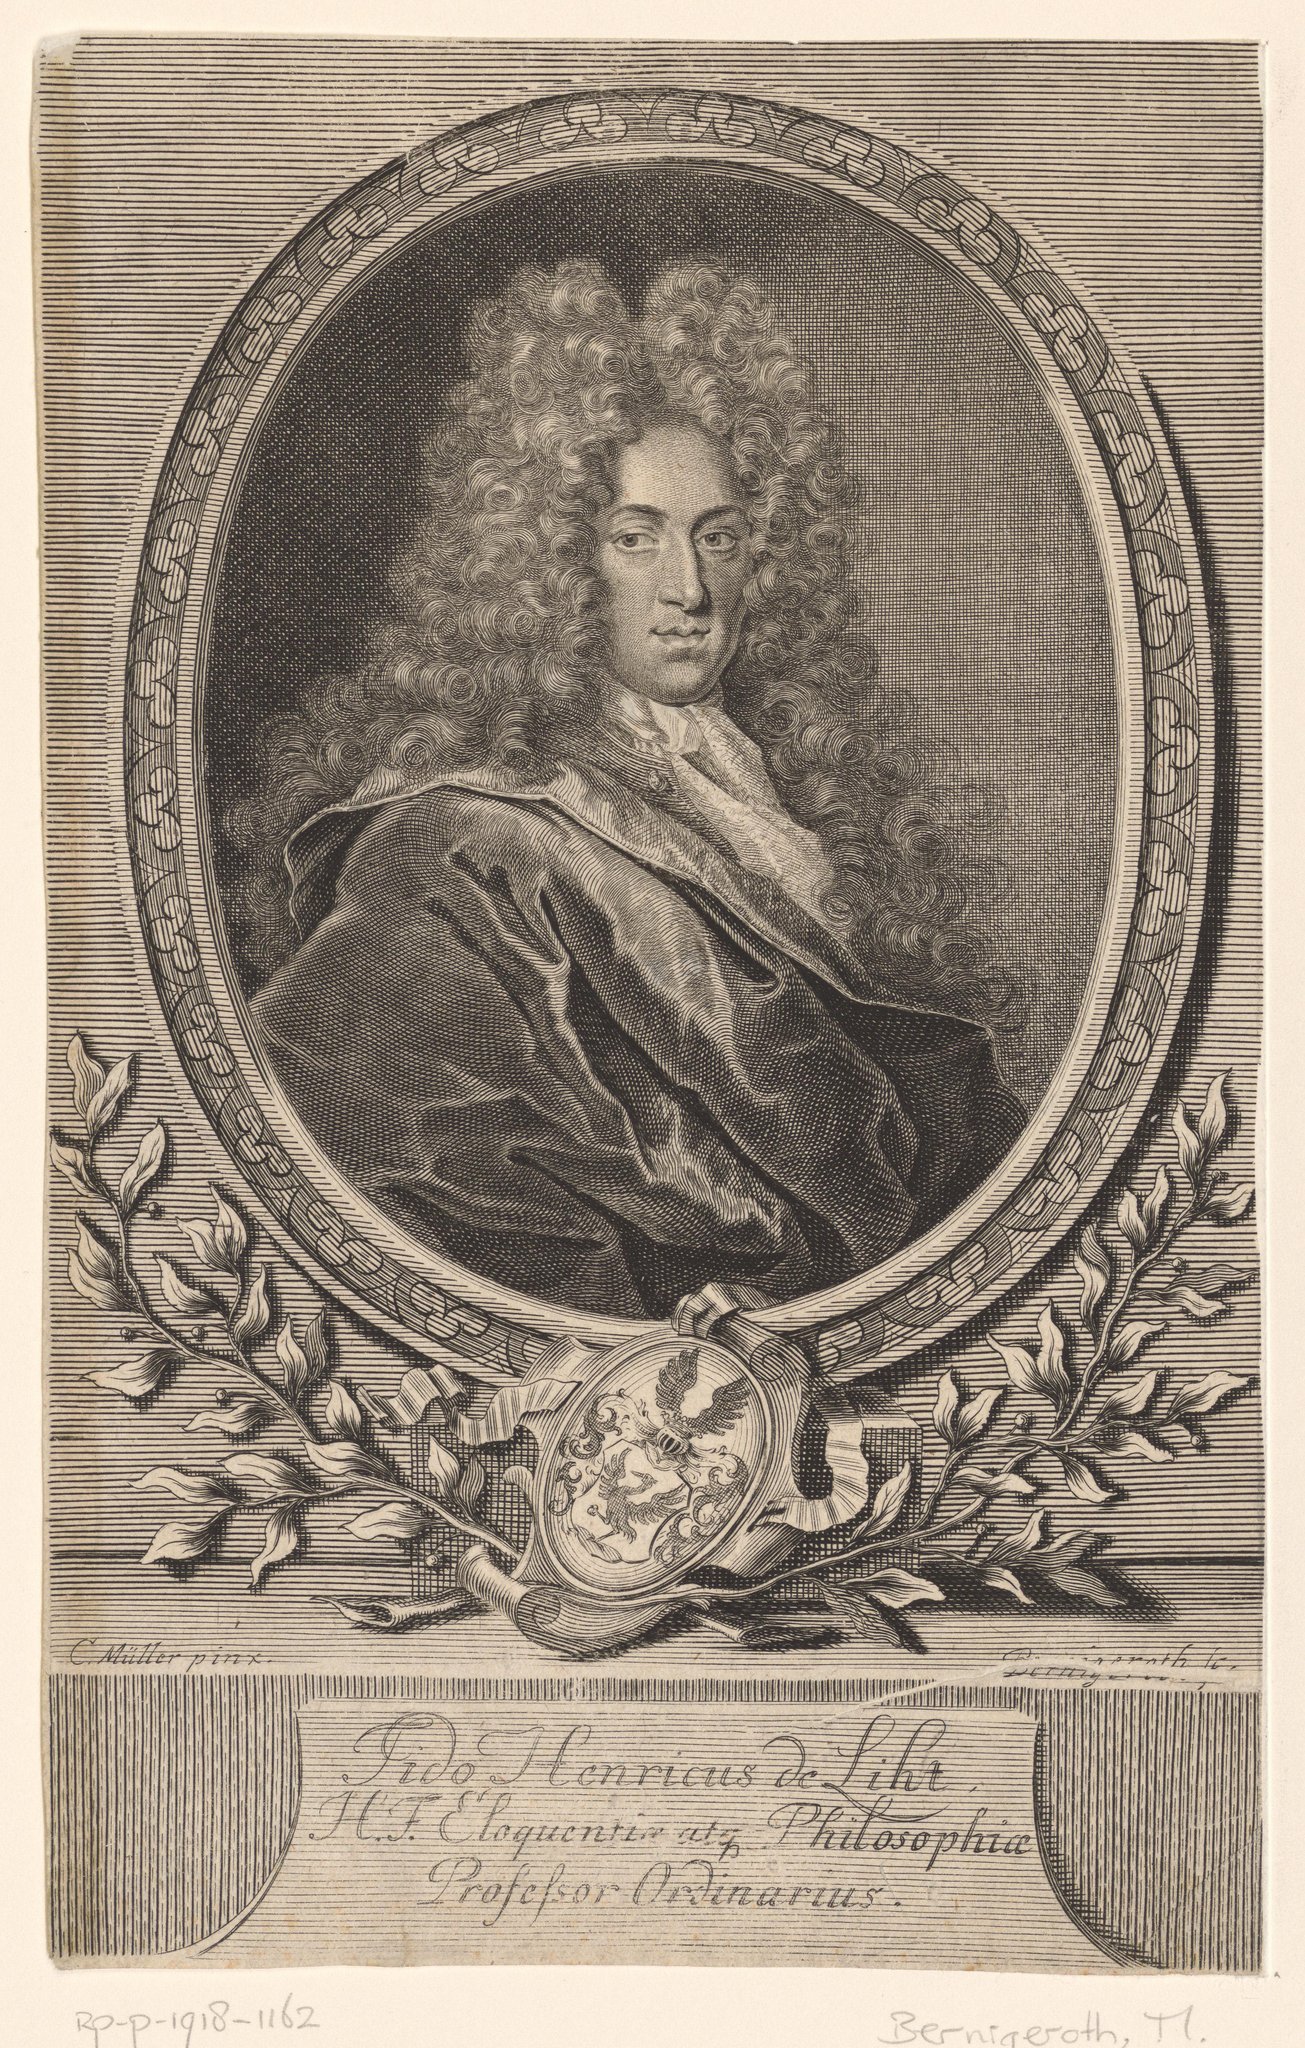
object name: print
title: Portret van Tido Heinrich II von der Lith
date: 1707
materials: paper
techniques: engraving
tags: ornament ~ medallion, historical persons, professor, armorial bearing, heraldry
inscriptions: collector's mark: Lugt 2233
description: Prent waarschijnlijk uit: Beckmann, Johann Christoph. Notitia Universitatis Francofurtanae (...). Frankfurt an der Oder: erven Jeremias Schrey en Johann Christoph Hartmann, 1707.